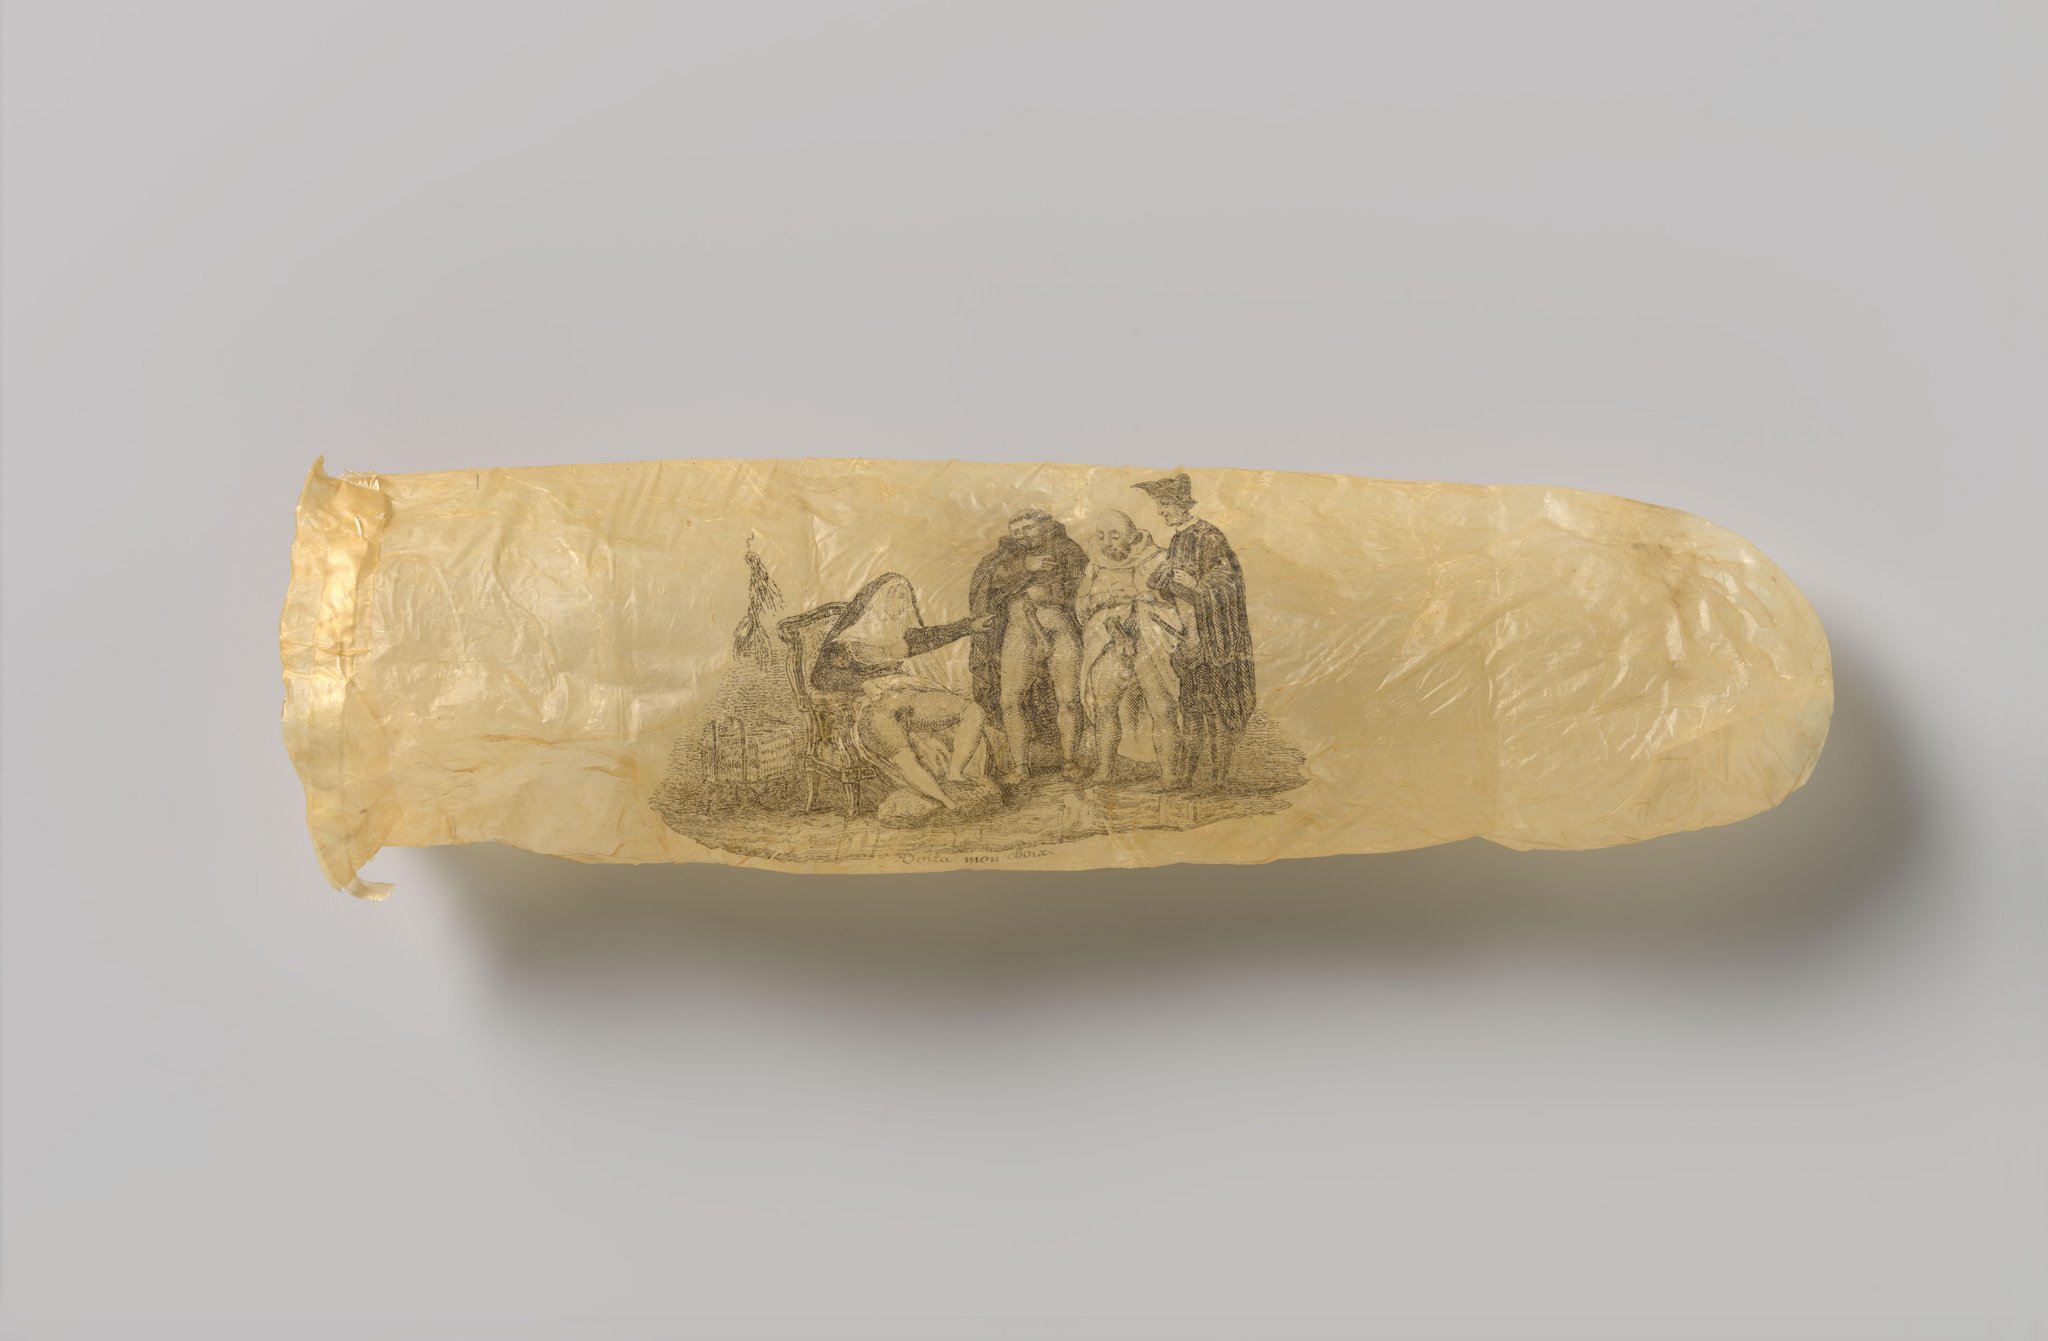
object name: print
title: Condoom met erotische voorstelling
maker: Anonymous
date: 1830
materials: ink, ribbon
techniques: etching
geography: france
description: Condoom van schapendarm met een erotische voorstelling daarop gedrukt in inkt. De voorstelling toont een non met ontblote borsten, zittend op een stoel links. Ze tilt haar habijt op en onthult haar naakte geslachtsdeel aan drie mannelijke geestelijken, die elk hun gewaden optillen en hun erecte geslachtsdelen tonen. De non wijst één van de mannen aan. De compositie roept associaties op met het oordeel van Paris. Onder de afbeelding staat de tekst: "Voilà mon choix" (“Dit is mijn keuze”). Aan het uiteinde van de schacht van het condoom zit een wit lintje om het condoom op zijn plek te houden tijdens gebruik.